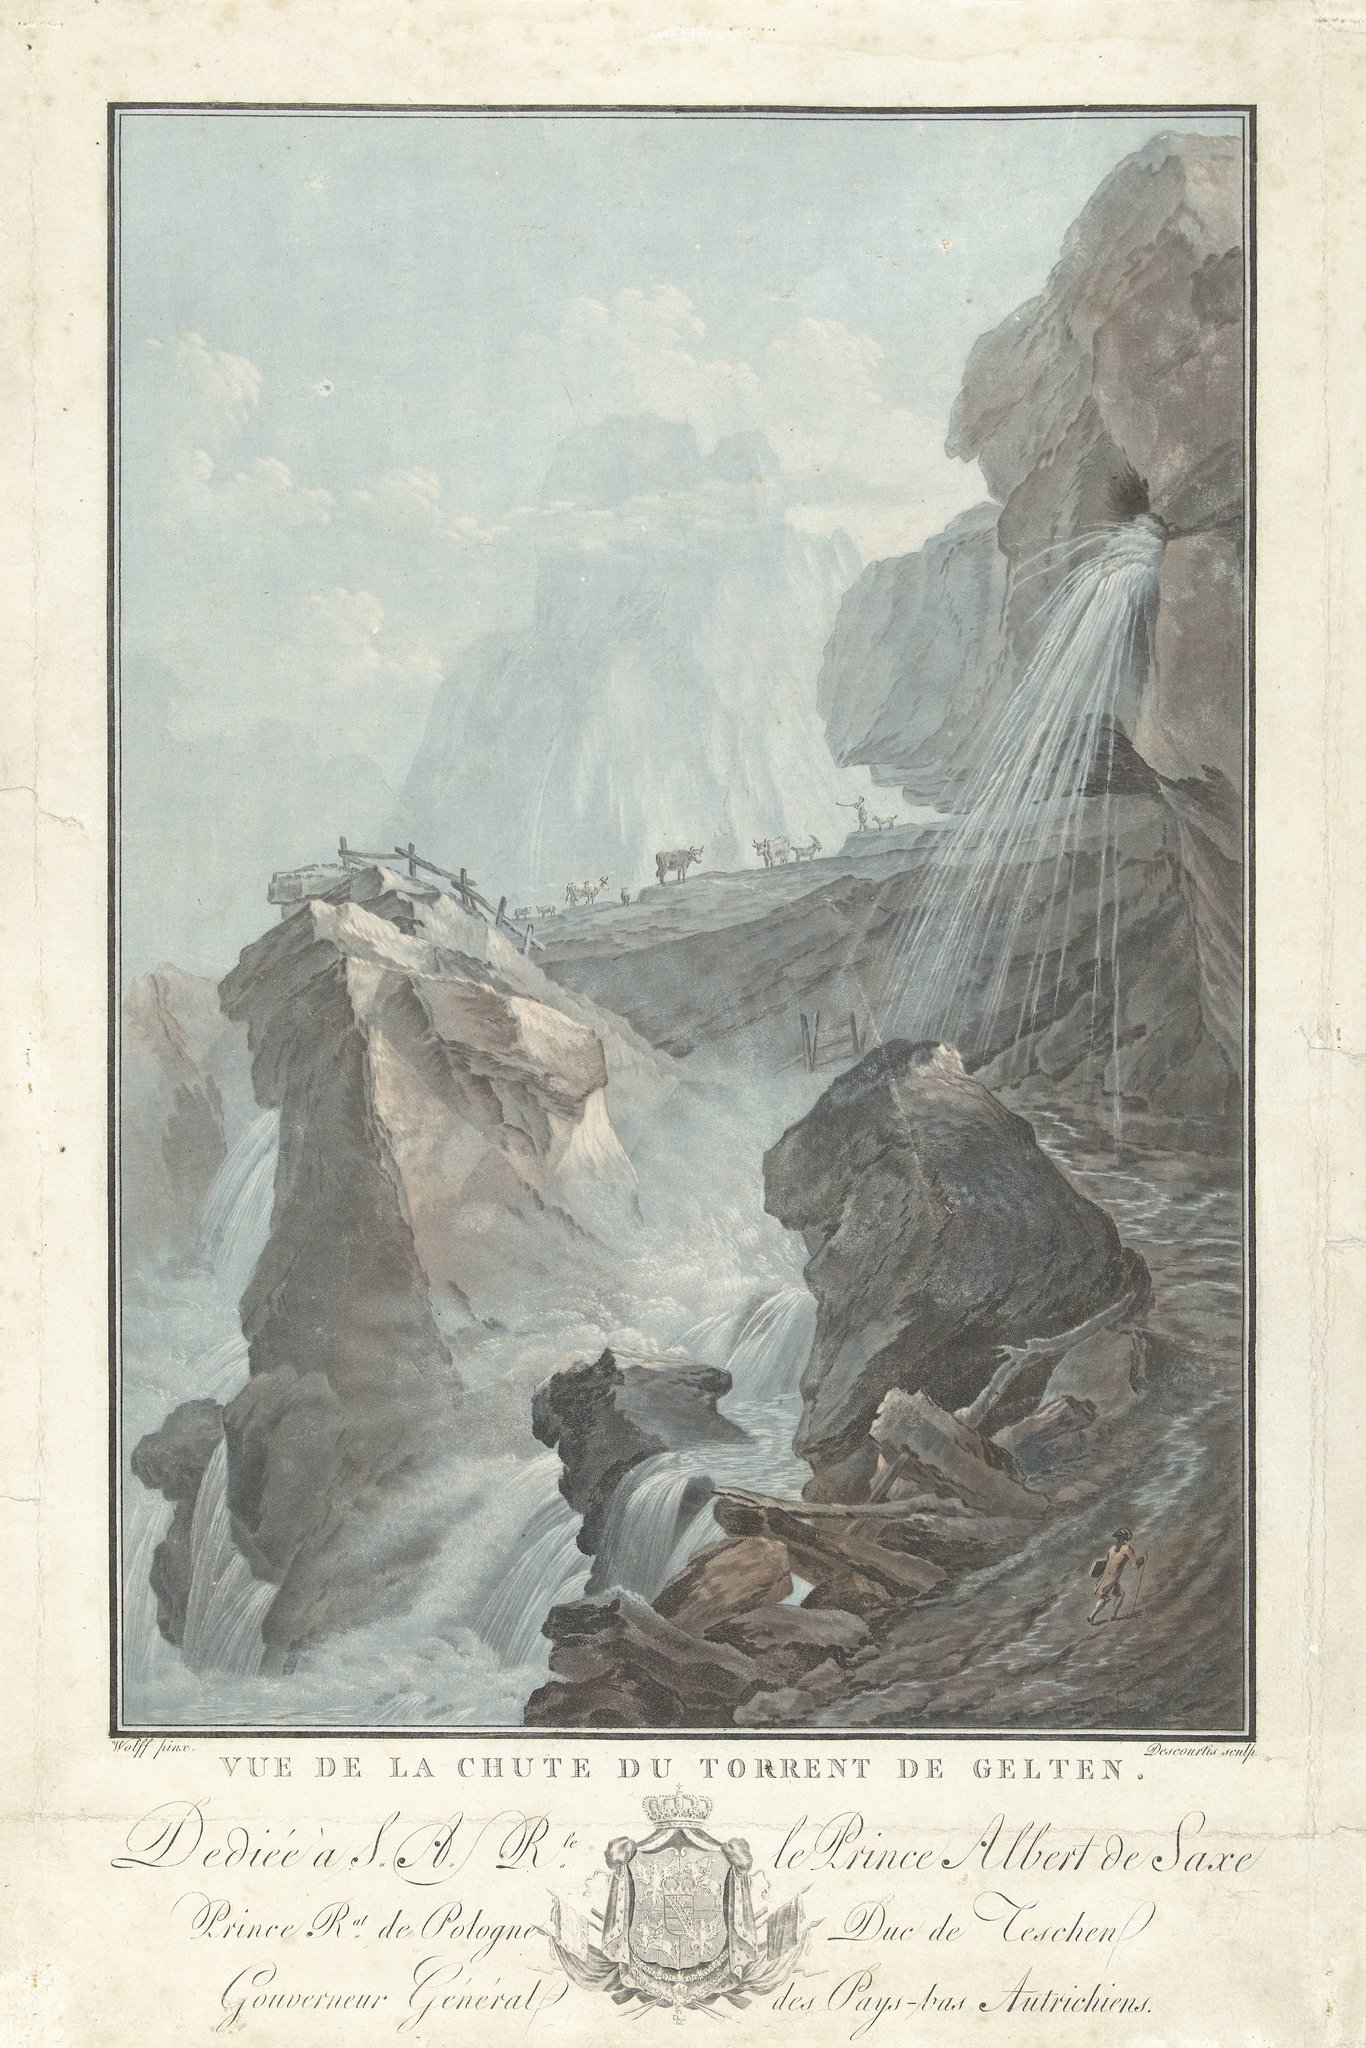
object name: print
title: Vues remarquables des montagnes de la Suisse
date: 1763-1785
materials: paper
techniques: etching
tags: waterfall, mountains, switzerland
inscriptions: collector's mark: Lugt 2228, collector's mark: Lugt 2760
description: Berglandschap met een wandelaar op een steil wandelpad naast een waterval. Aan de overzijde een herder met zijn kudde. Onder de voorstelling tekst en een wapenschild.